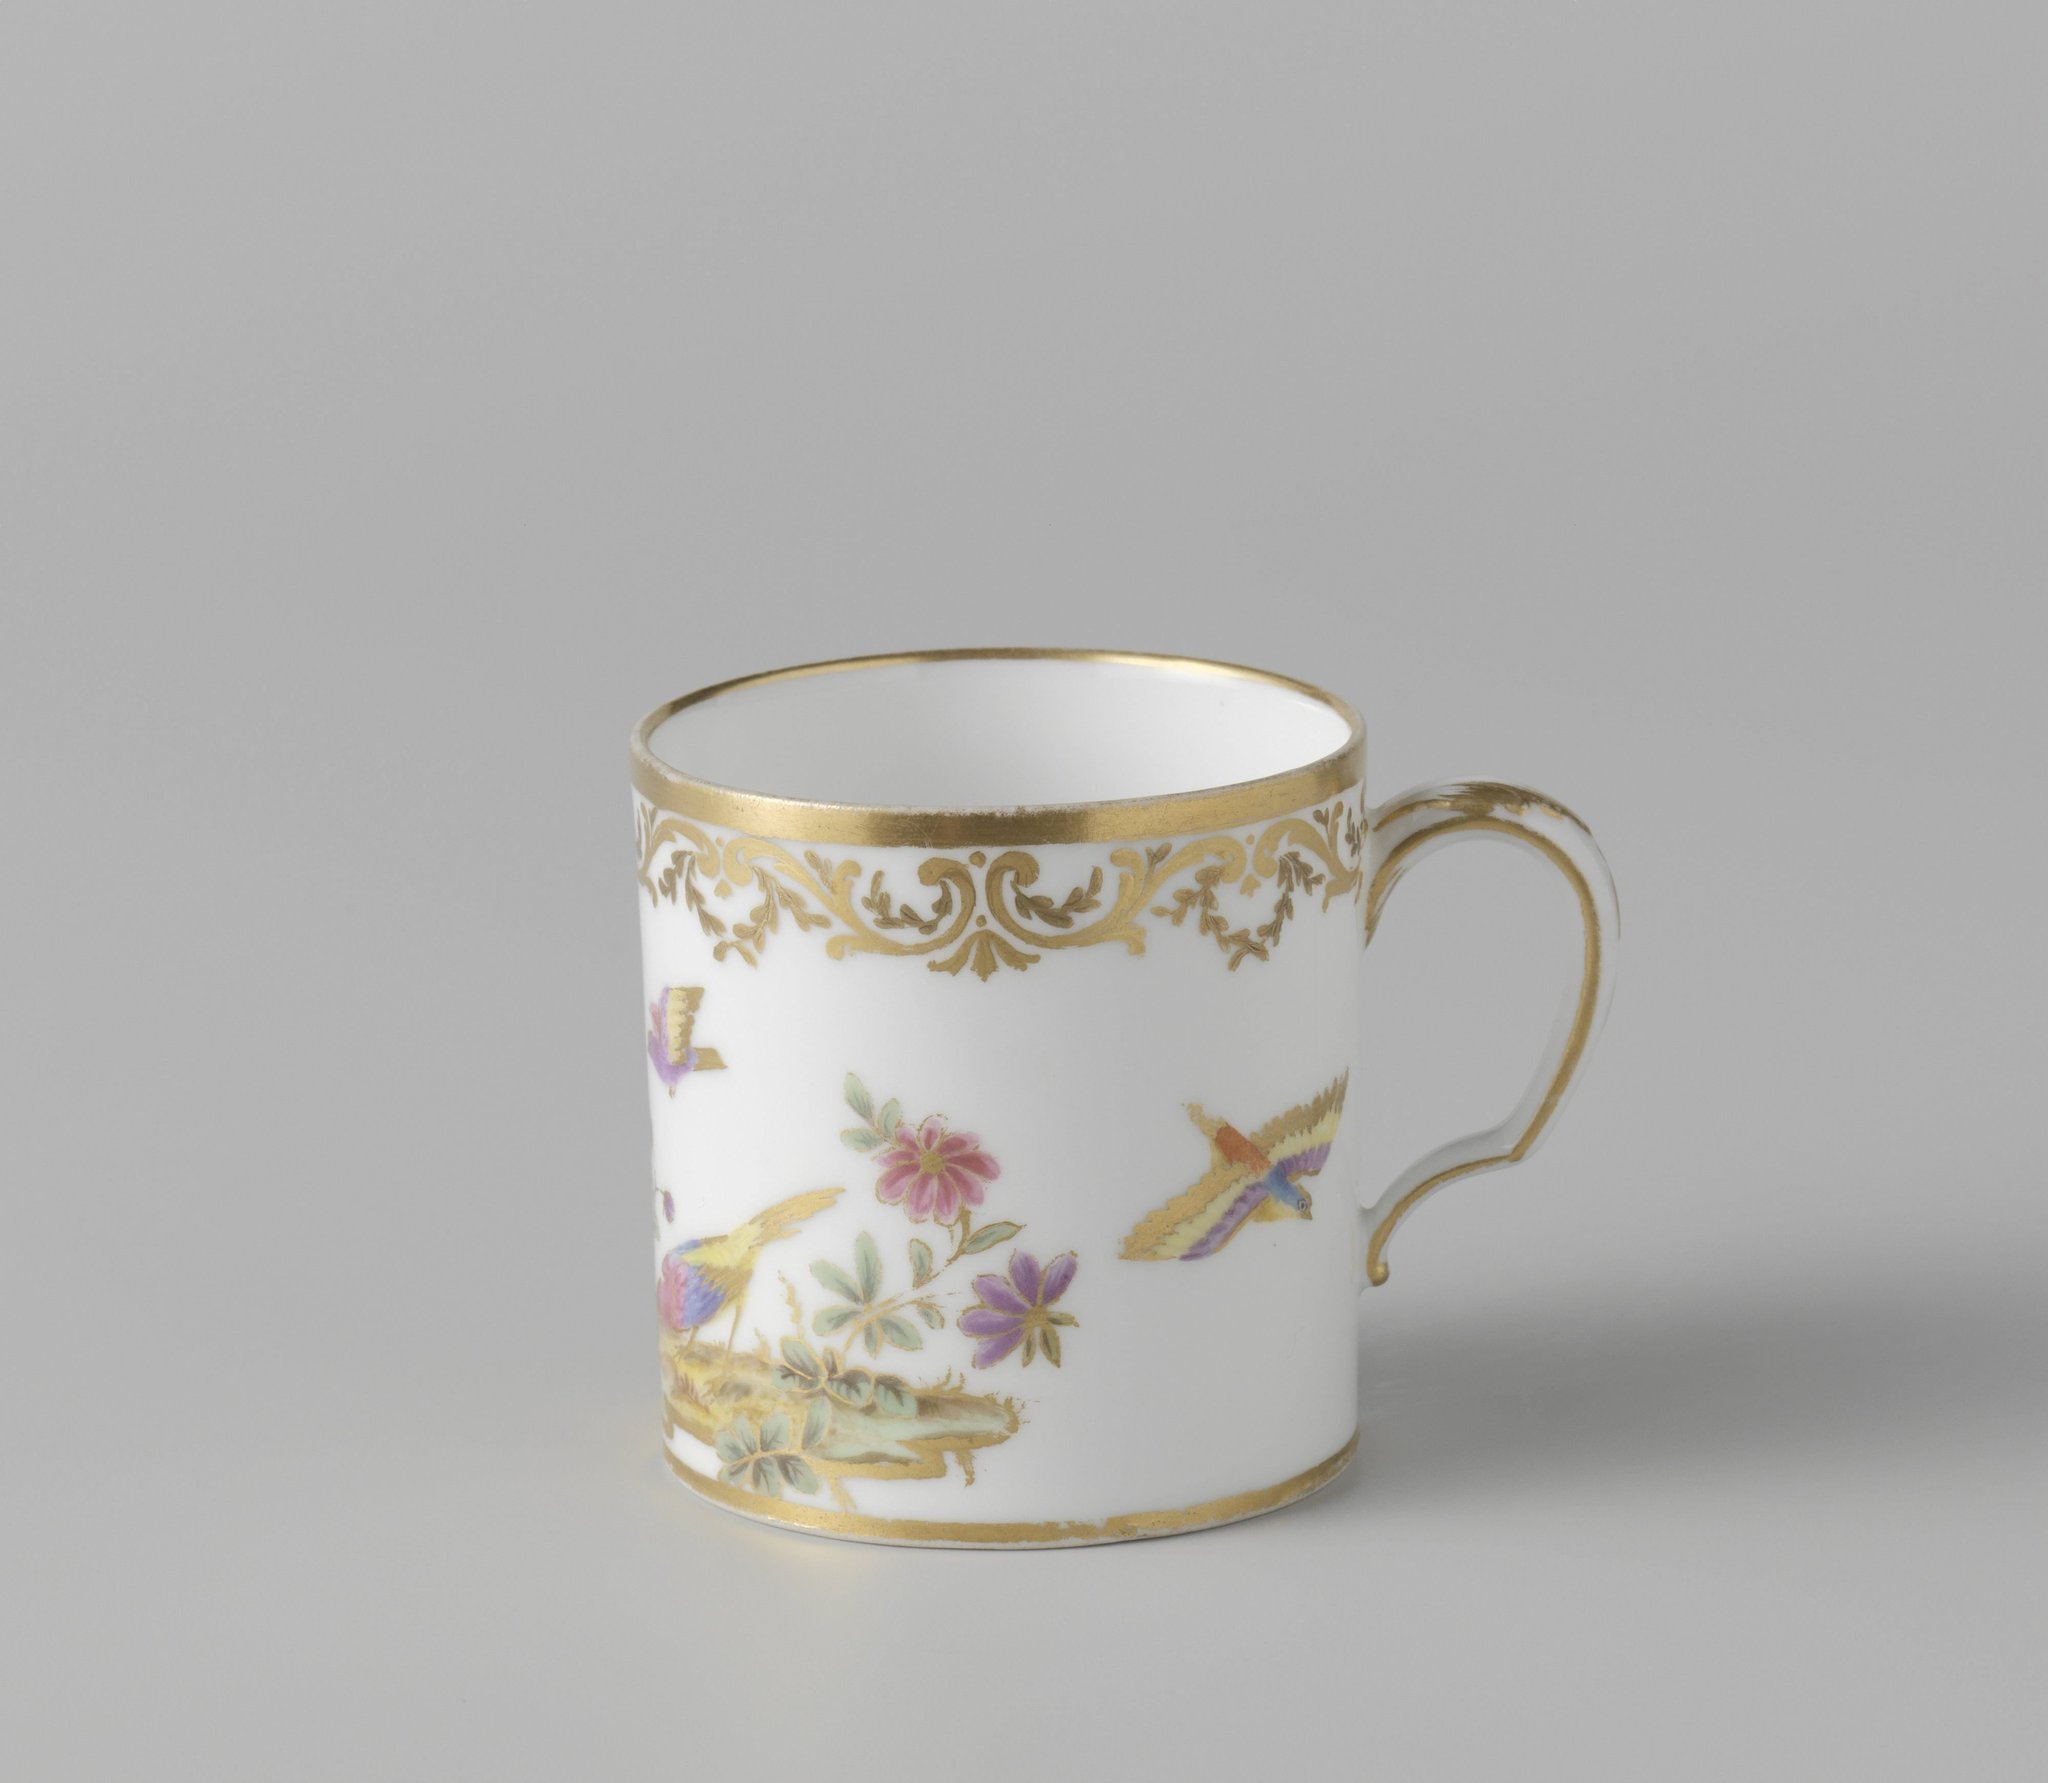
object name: cup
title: Tea service with tray (déjeuner Bolvry)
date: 1779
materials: porcelain, silver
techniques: gilding, painted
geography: sèvres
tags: birds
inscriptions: mark: ‘Ma’, factory mark, mark: ‘HP’, painter's mark: ‘F.’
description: The Sèvres factory succeeded in making true hard-paste porcelain containing kaolin (white clay) only in 1769. Many new patterns were developed for this kind of porcelain. The painted decoration of this service was influenced by patterned calico fabric (chintz) from India and by enamel from China.